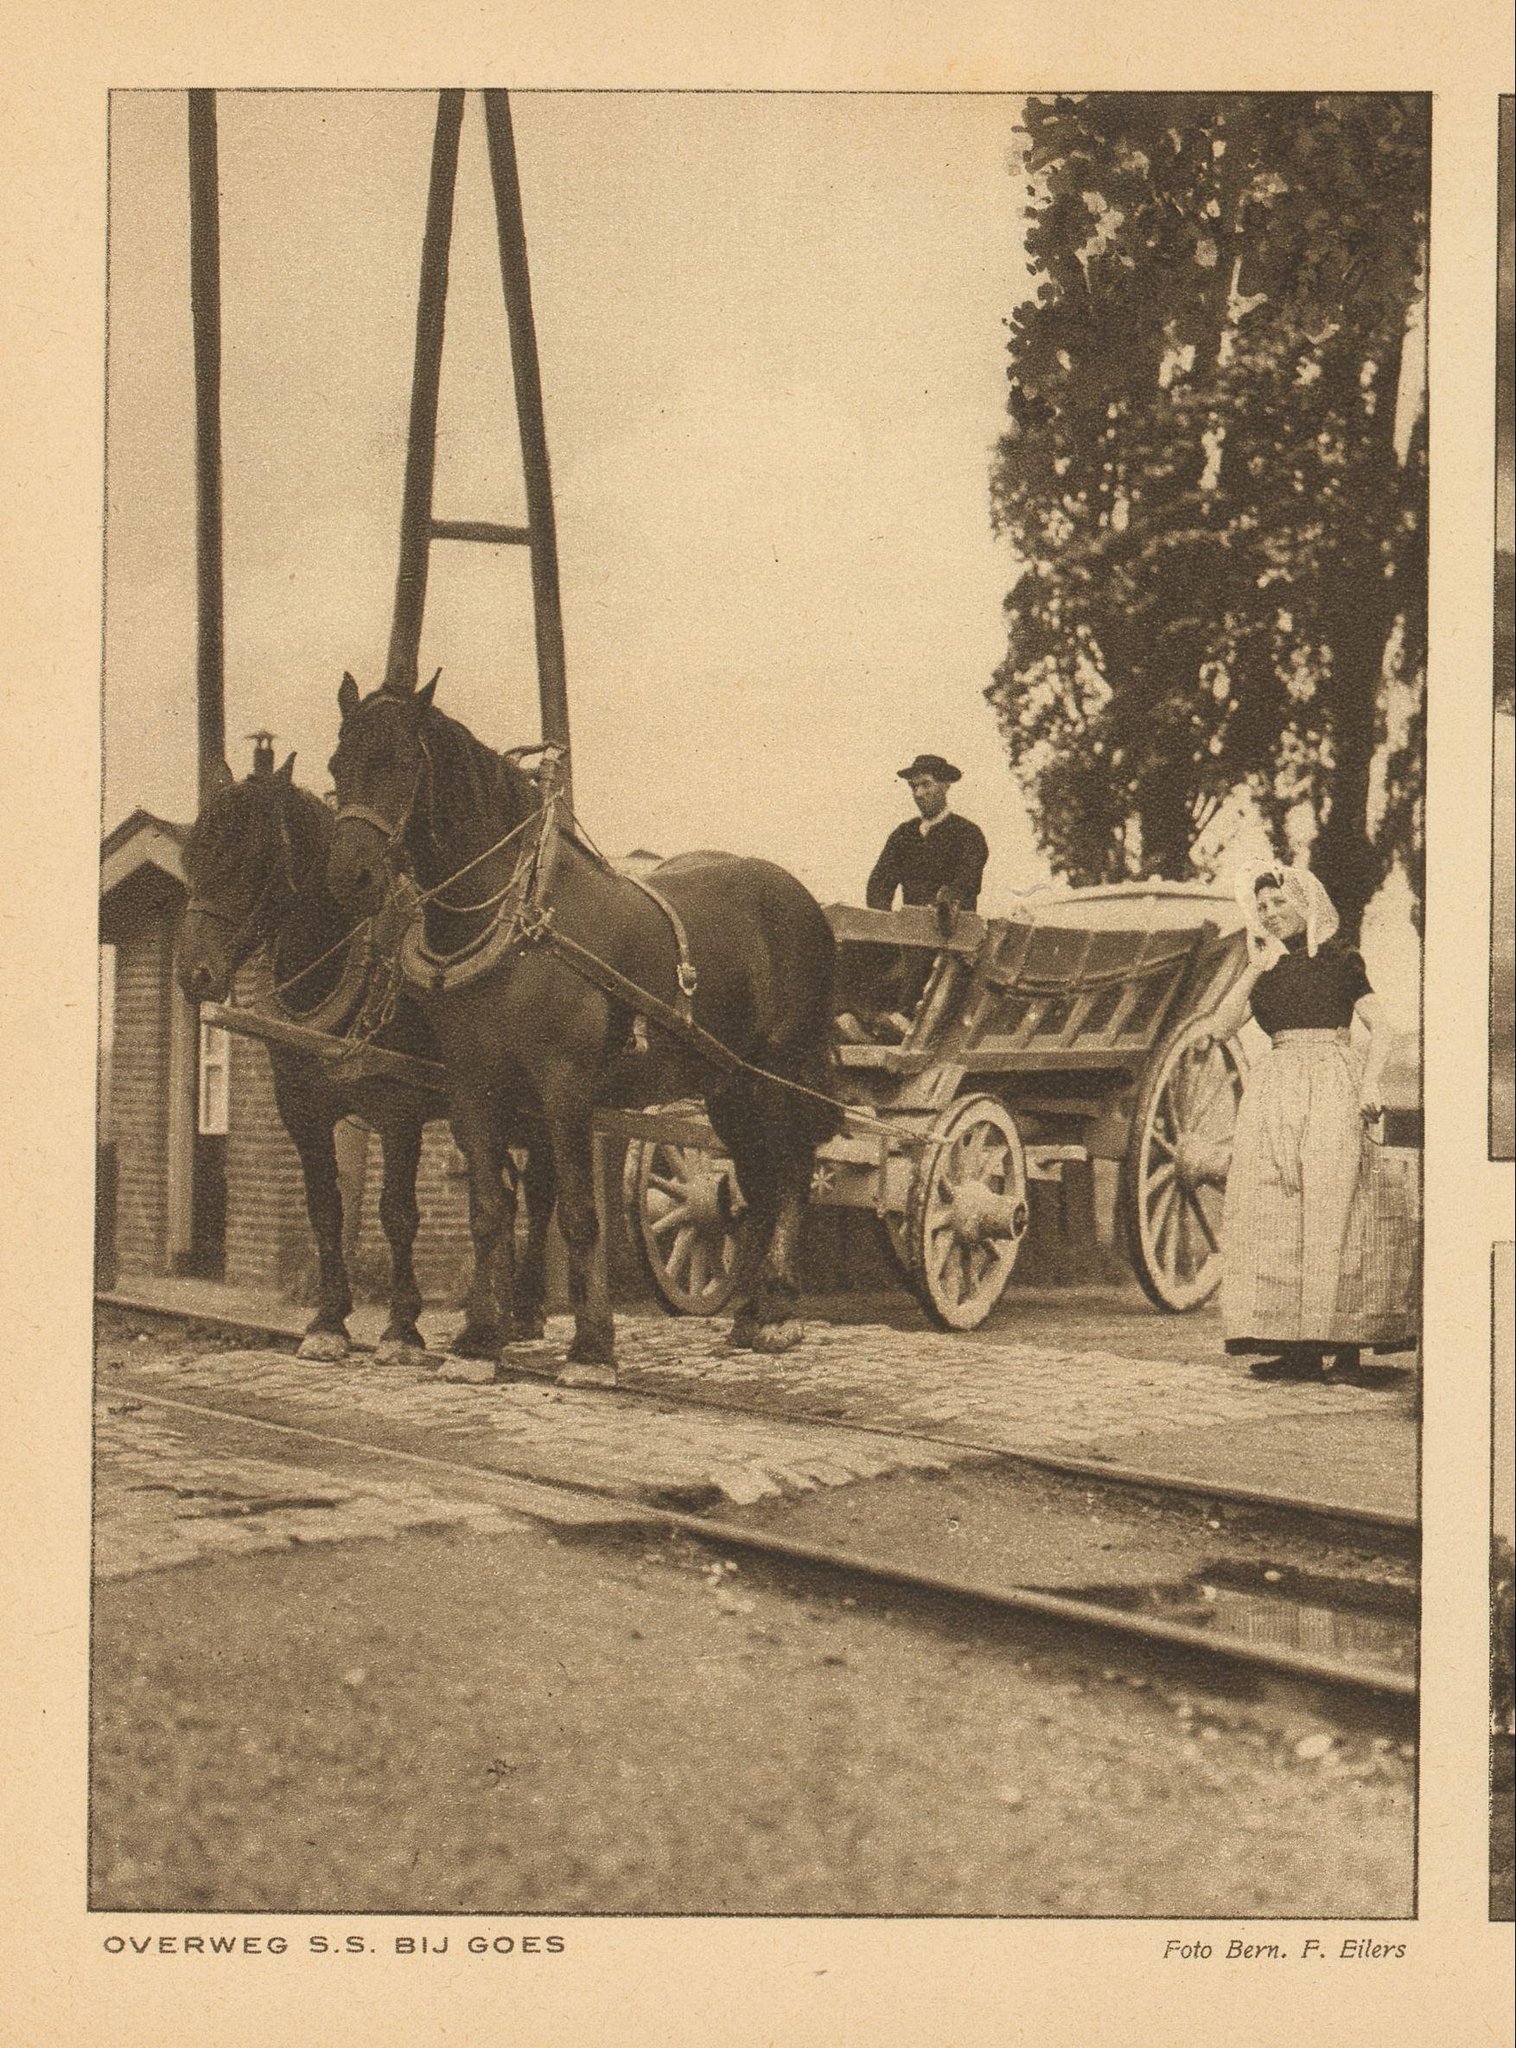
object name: album leaf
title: Paard en wagen bij een overweg van de Staatsspoorwegen in Goes, Zeeland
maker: bernard eilers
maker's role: fotograaf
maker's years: 1878-1951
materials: paper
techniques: rotogravure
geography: goes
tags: unguarded level-crossing (railway, tramway), four-wheeled vehicle drawn by two animals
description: Deze prent maakt deel uit van een album.